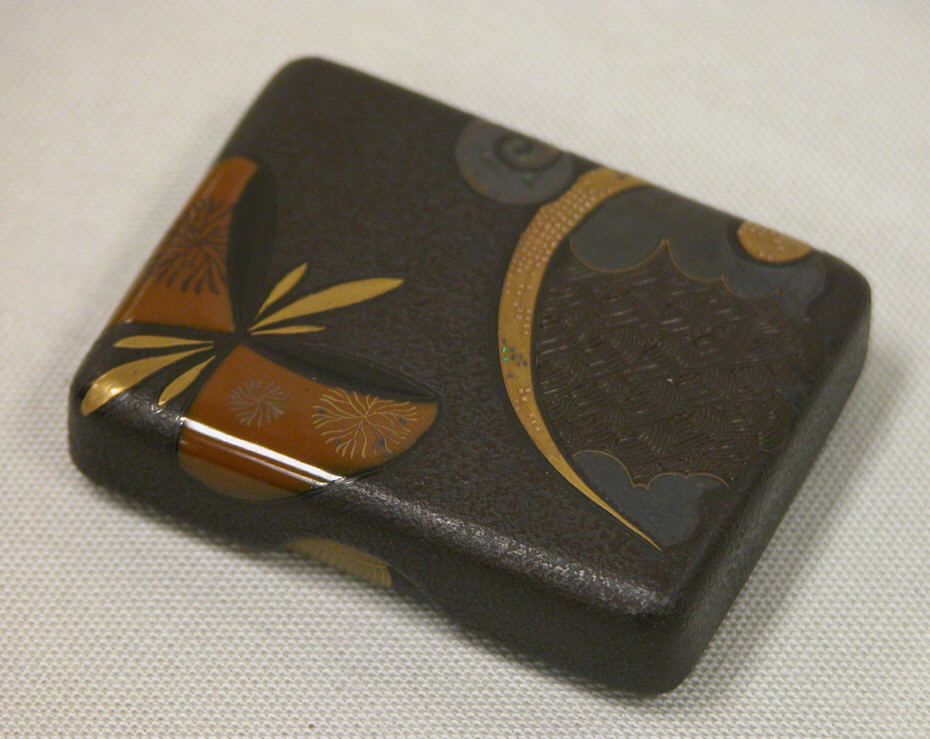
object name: box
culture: japanese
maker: shibata zeshin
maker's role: artist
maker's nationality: japanese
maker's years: 1807-1891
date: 1801-1900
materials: lacquer